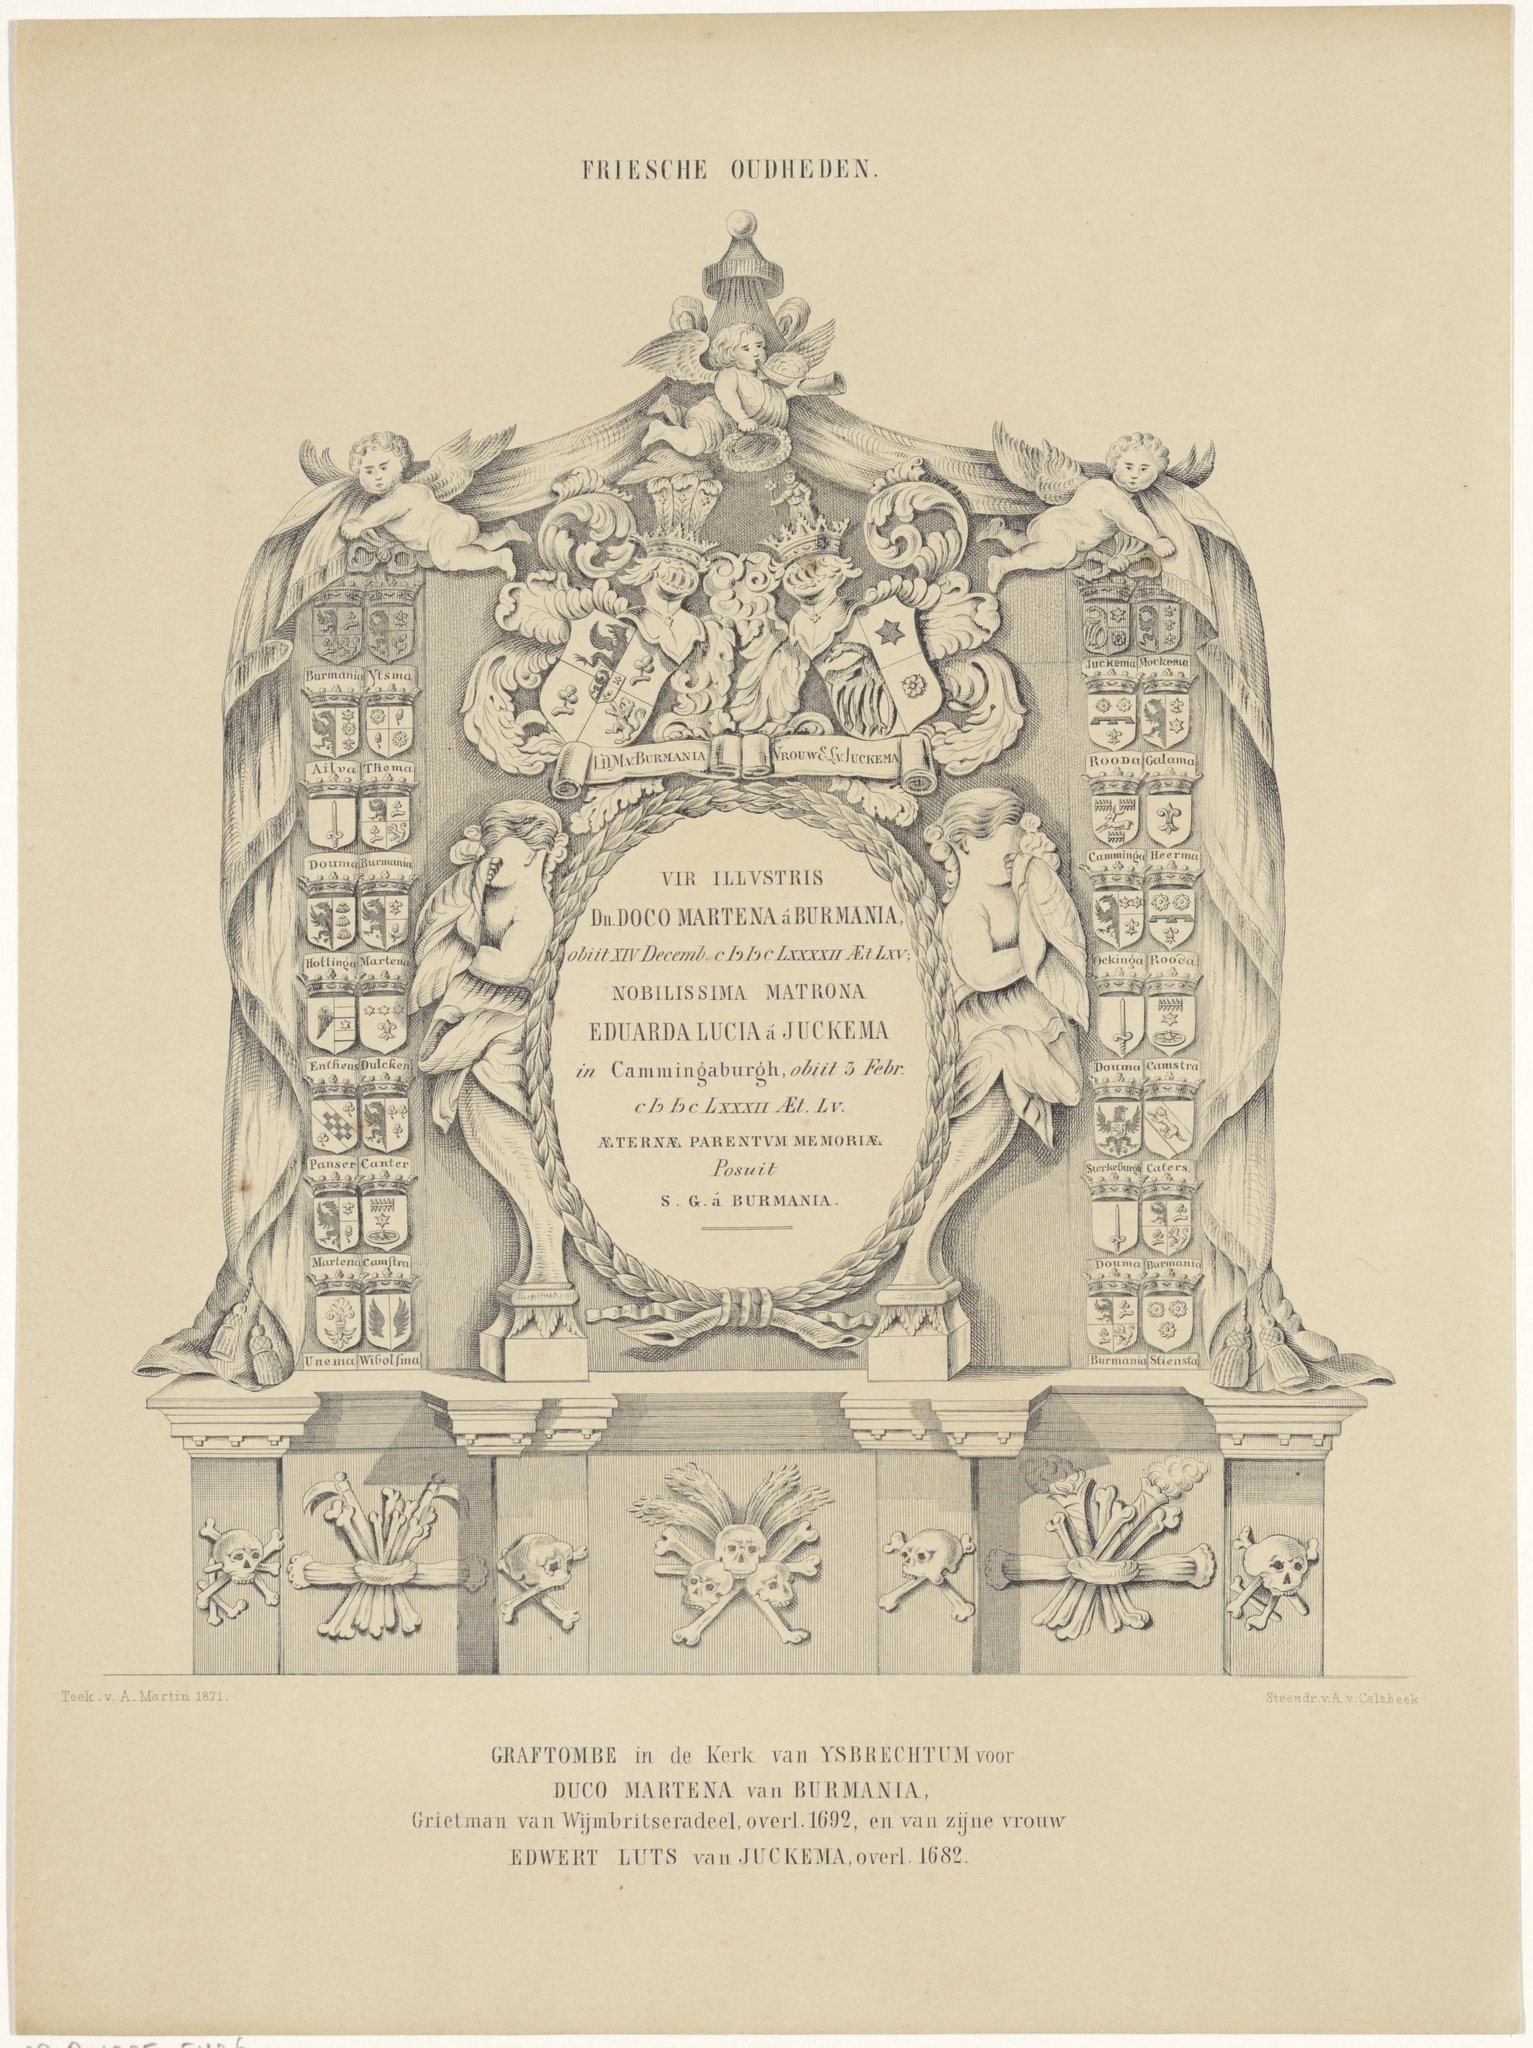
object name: book illustration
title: Grafmonument van Duco Martena vna Burmania en zijn vrouw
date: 1871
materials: paper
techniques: lithograph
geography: leeuwarden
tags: niche-tomb, wall-tomb, cupids: 'amores', 'amoretti', 'putti', armorial bearing, heraldry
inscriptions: collector's mark: Lugt 2228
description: Links en rechts van het grafschrift staan twee halffiguren met hun handen voor het gezicht. Daarboven twee familiewapens van de familie Burmania en Van Juckema. Drie putti houden een baldakijn omhoog met daaronder, links en rechts, rijen wapenschilden. Onderin een rand gedecoreerd met botten, schedels, sikkels, graan en fakkels. Onder de afbeelding de namen en sterfdata van de overledenen.